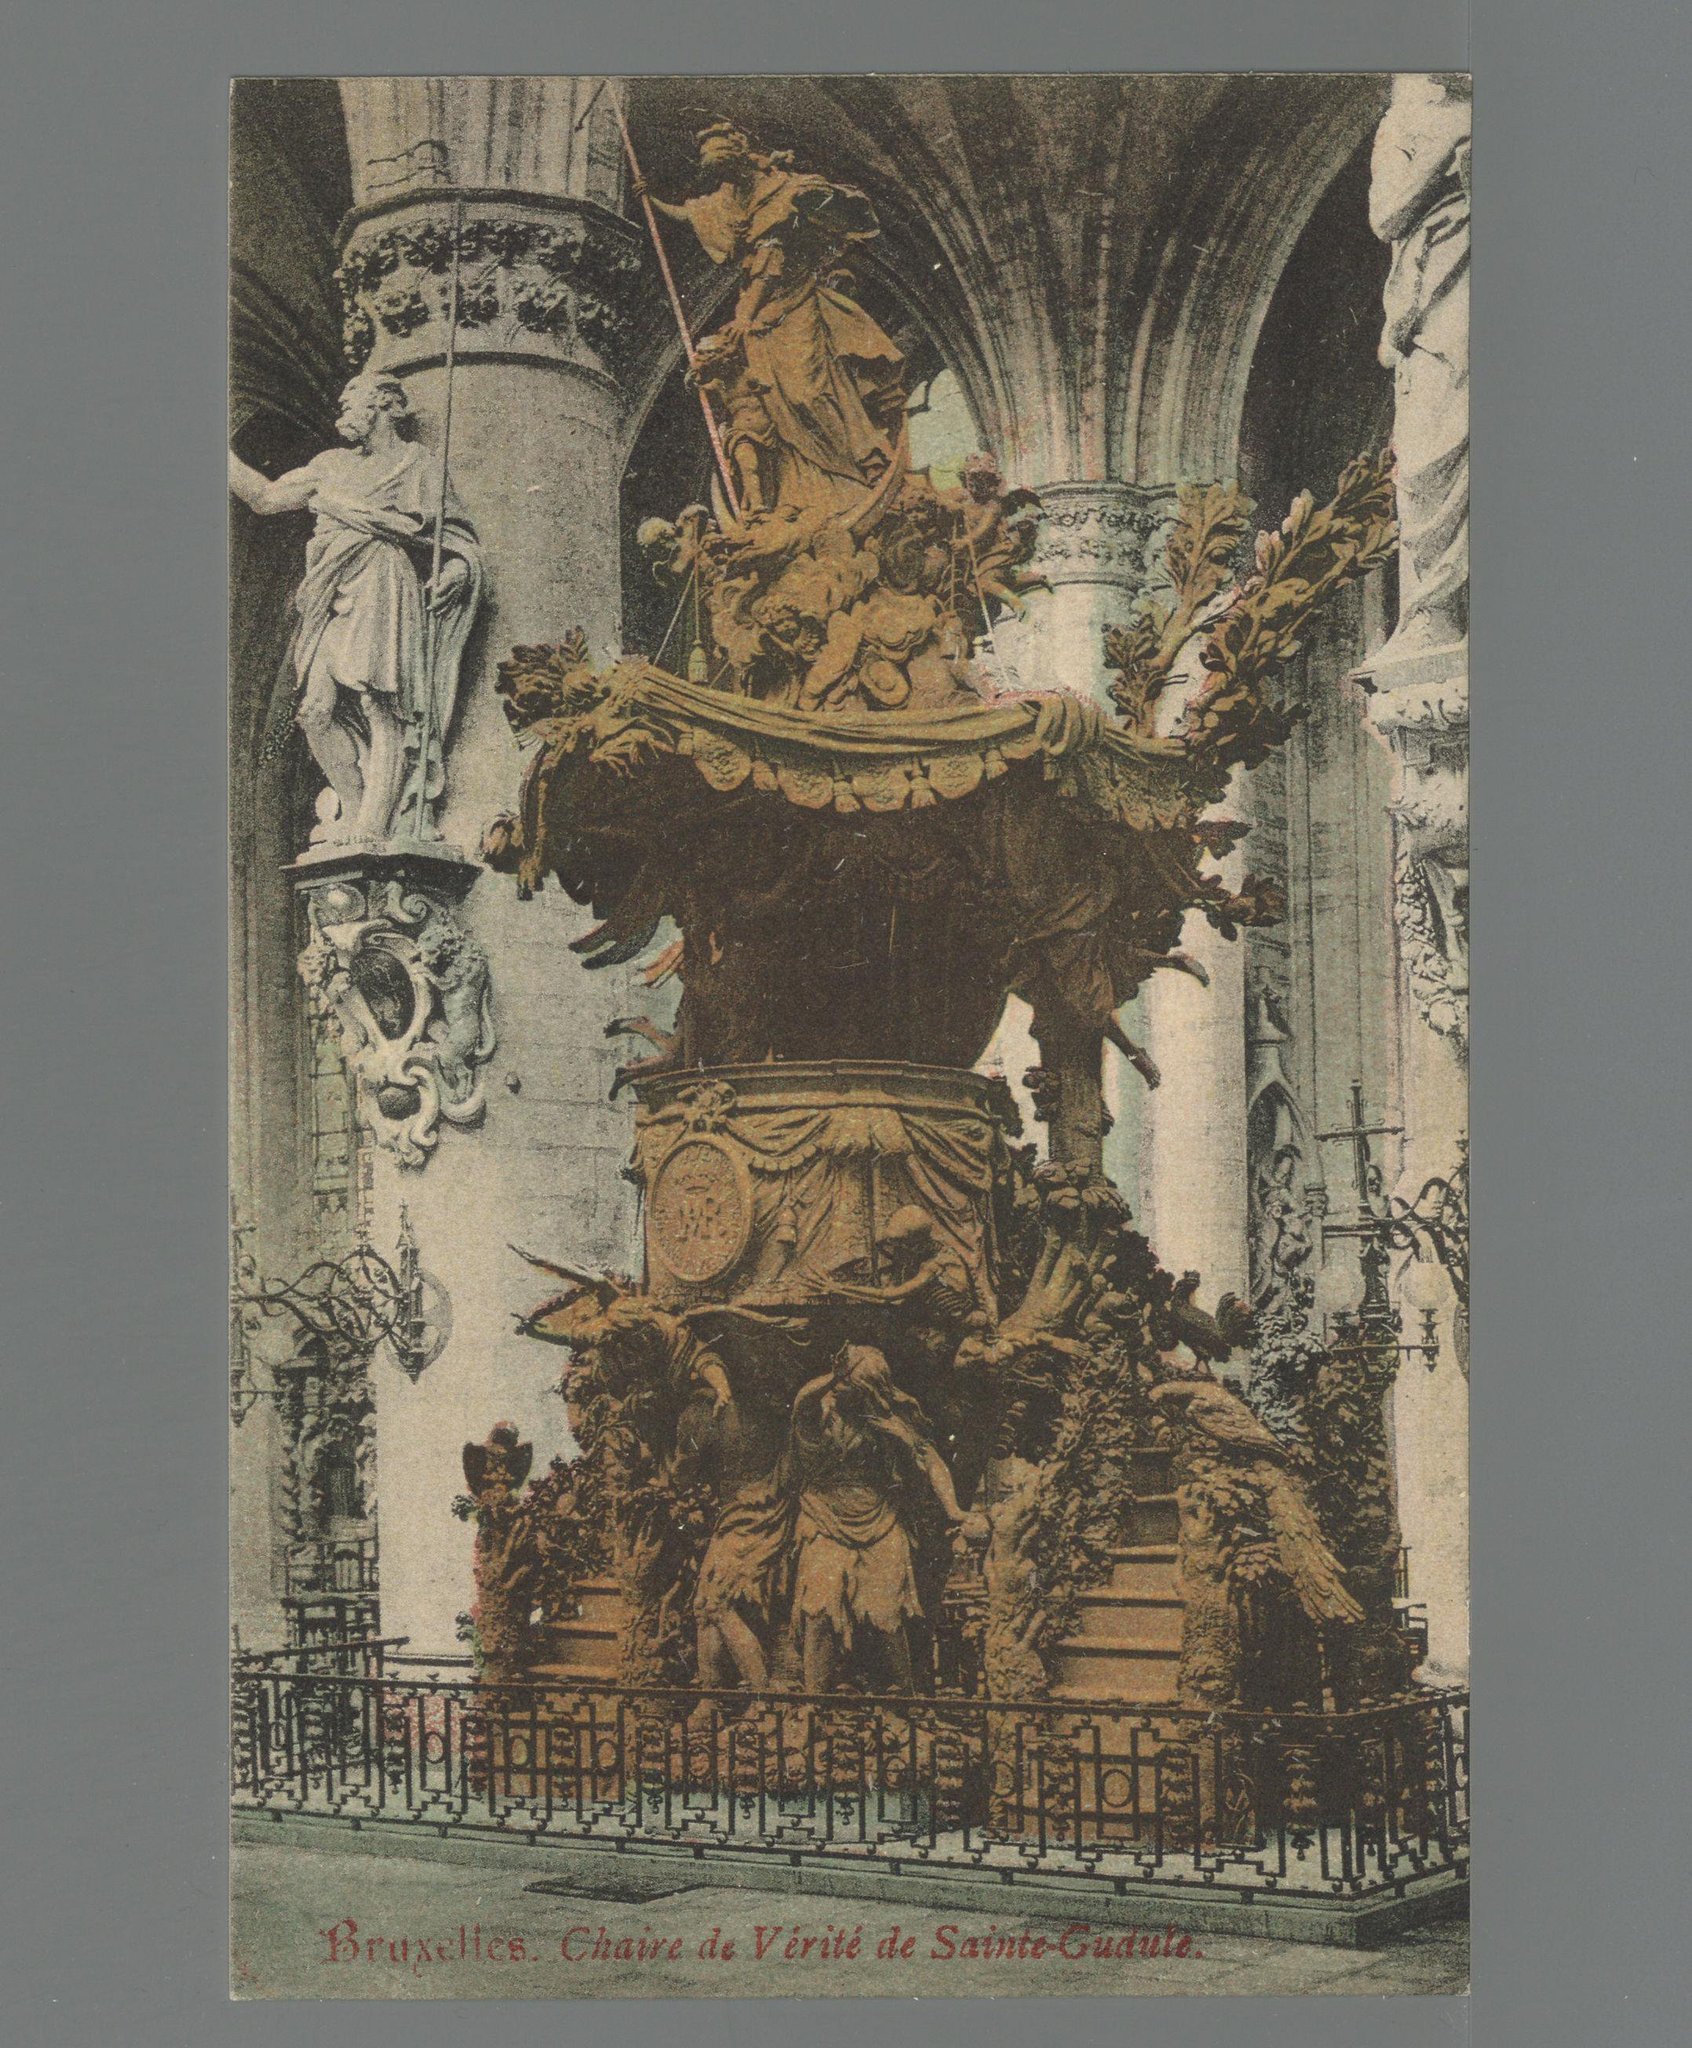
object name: photomechanical print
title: Bruxelles. Chaire de Vérité de Sainte-Gudule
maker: Anonymous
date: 1906-1930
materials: cardboard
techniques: photograph, lithograph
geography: brussels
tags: interior of church, pulpit, ambo, chancel